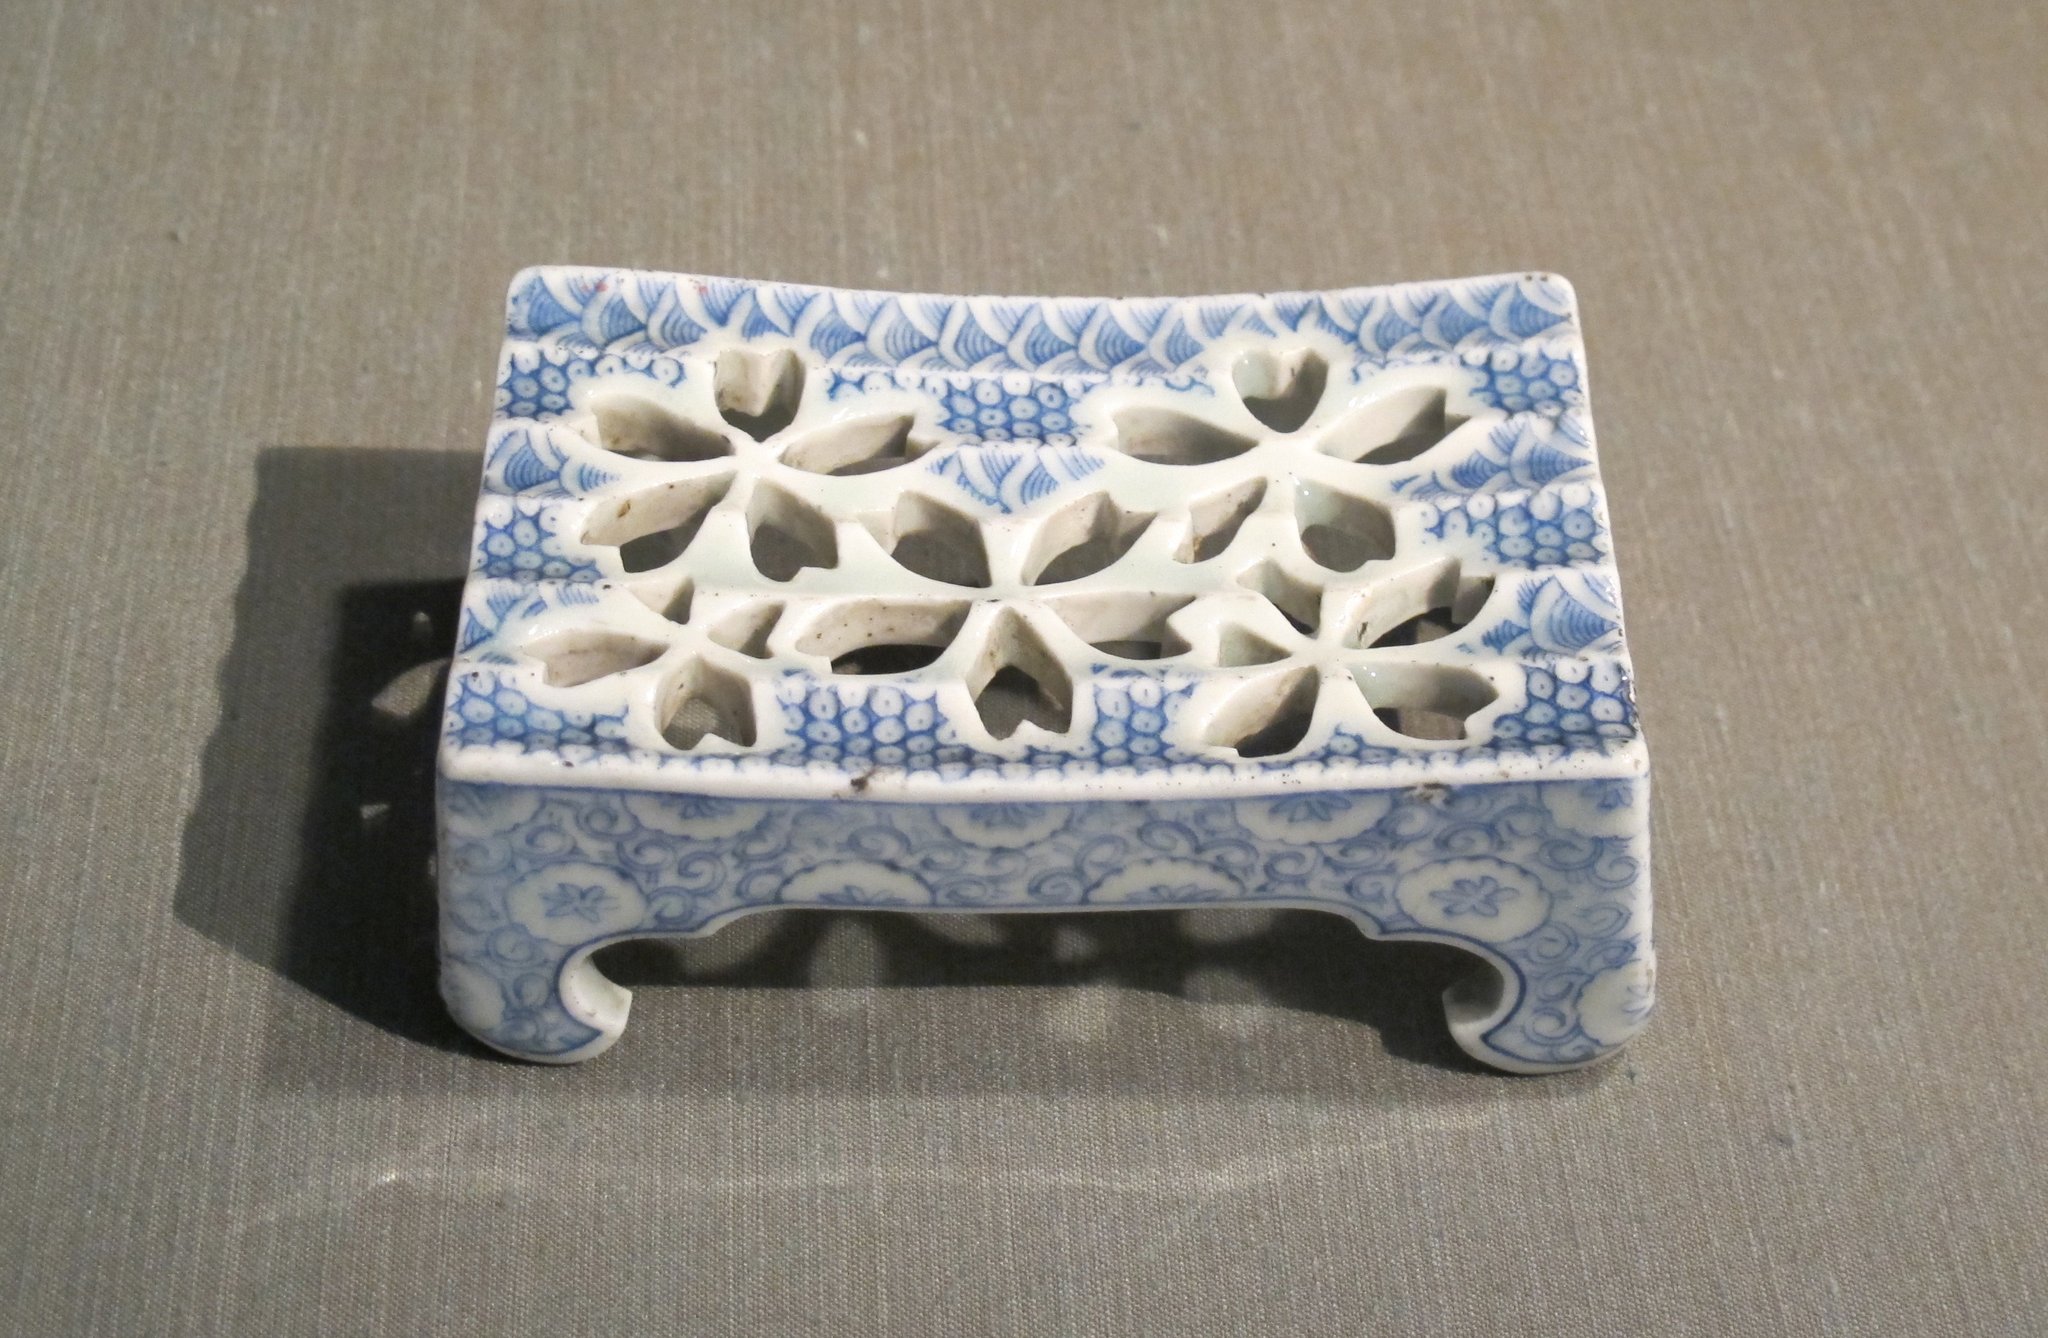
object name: inkstand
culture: japanese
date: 1834-1866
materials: porcelain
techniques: underglaze